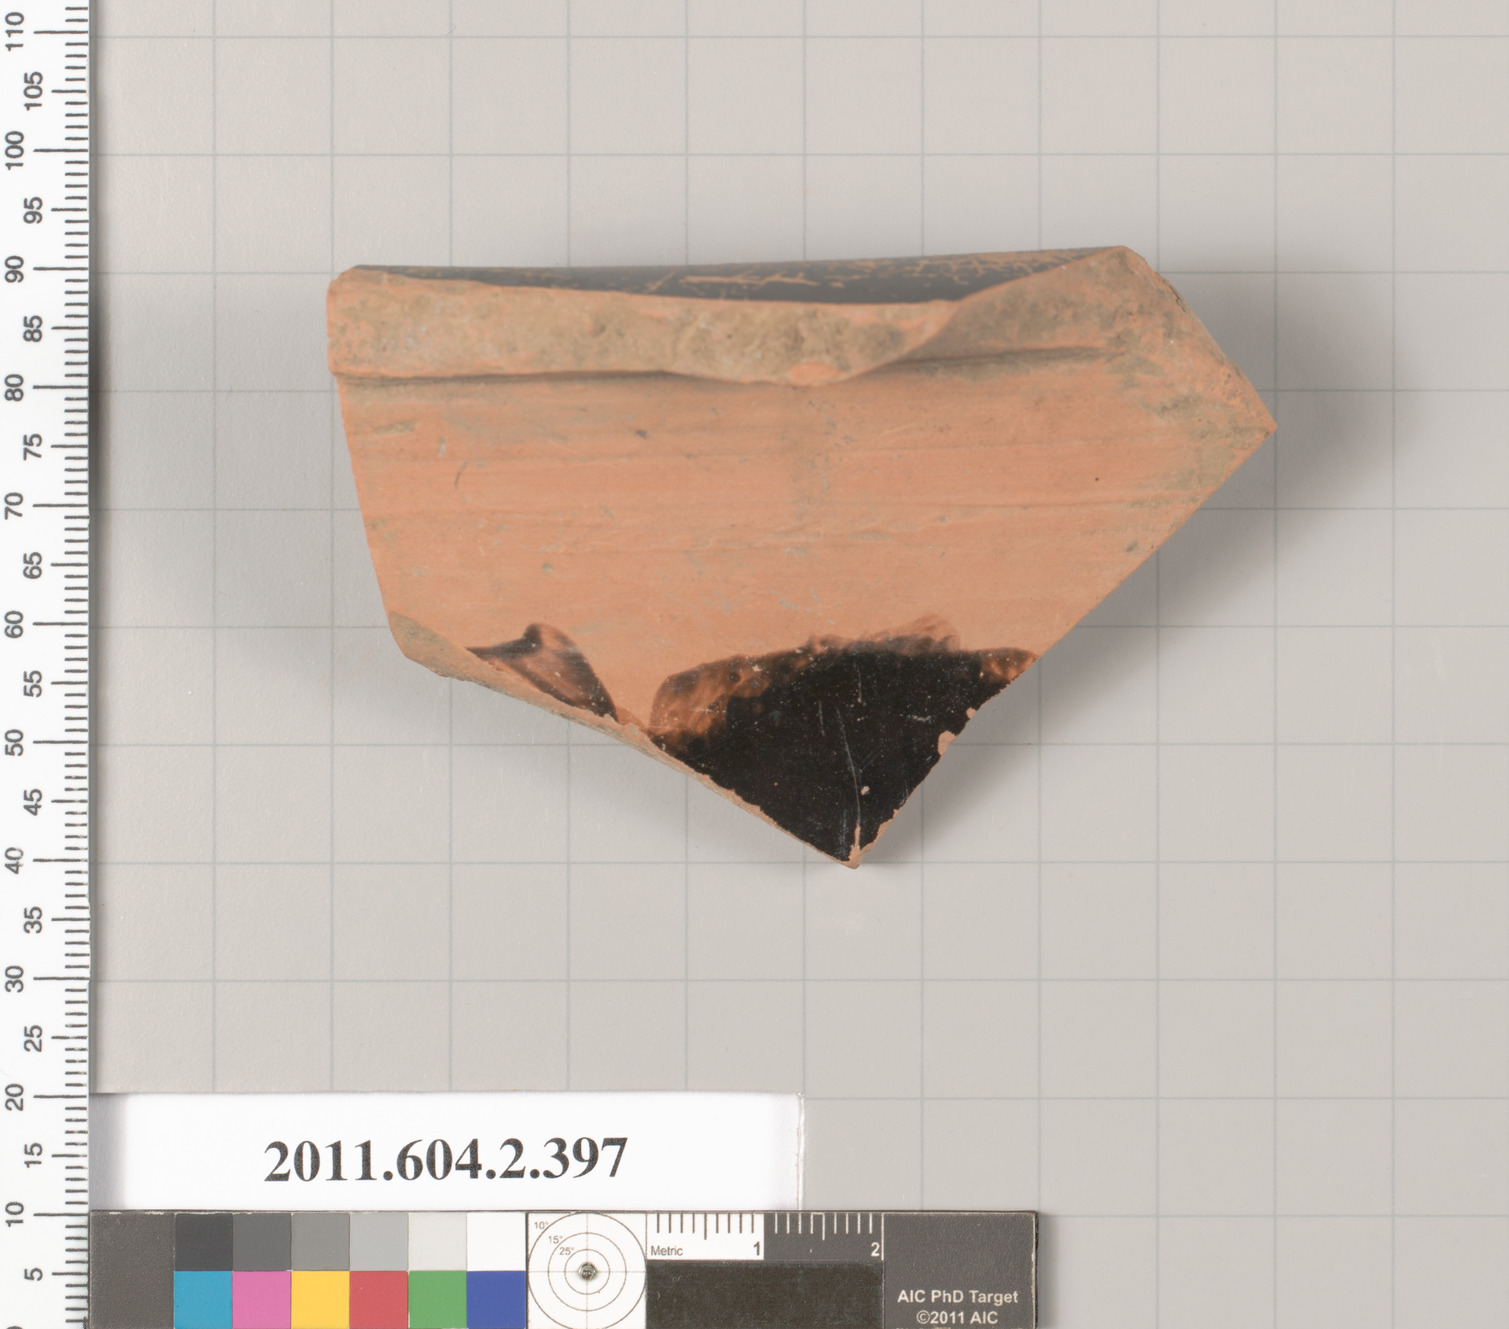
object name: column krater fragment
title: Terracotta fragment of a column-krater (bowl for mixing wine and water)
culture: greek, attic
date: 475-451 BCE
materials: terracotta